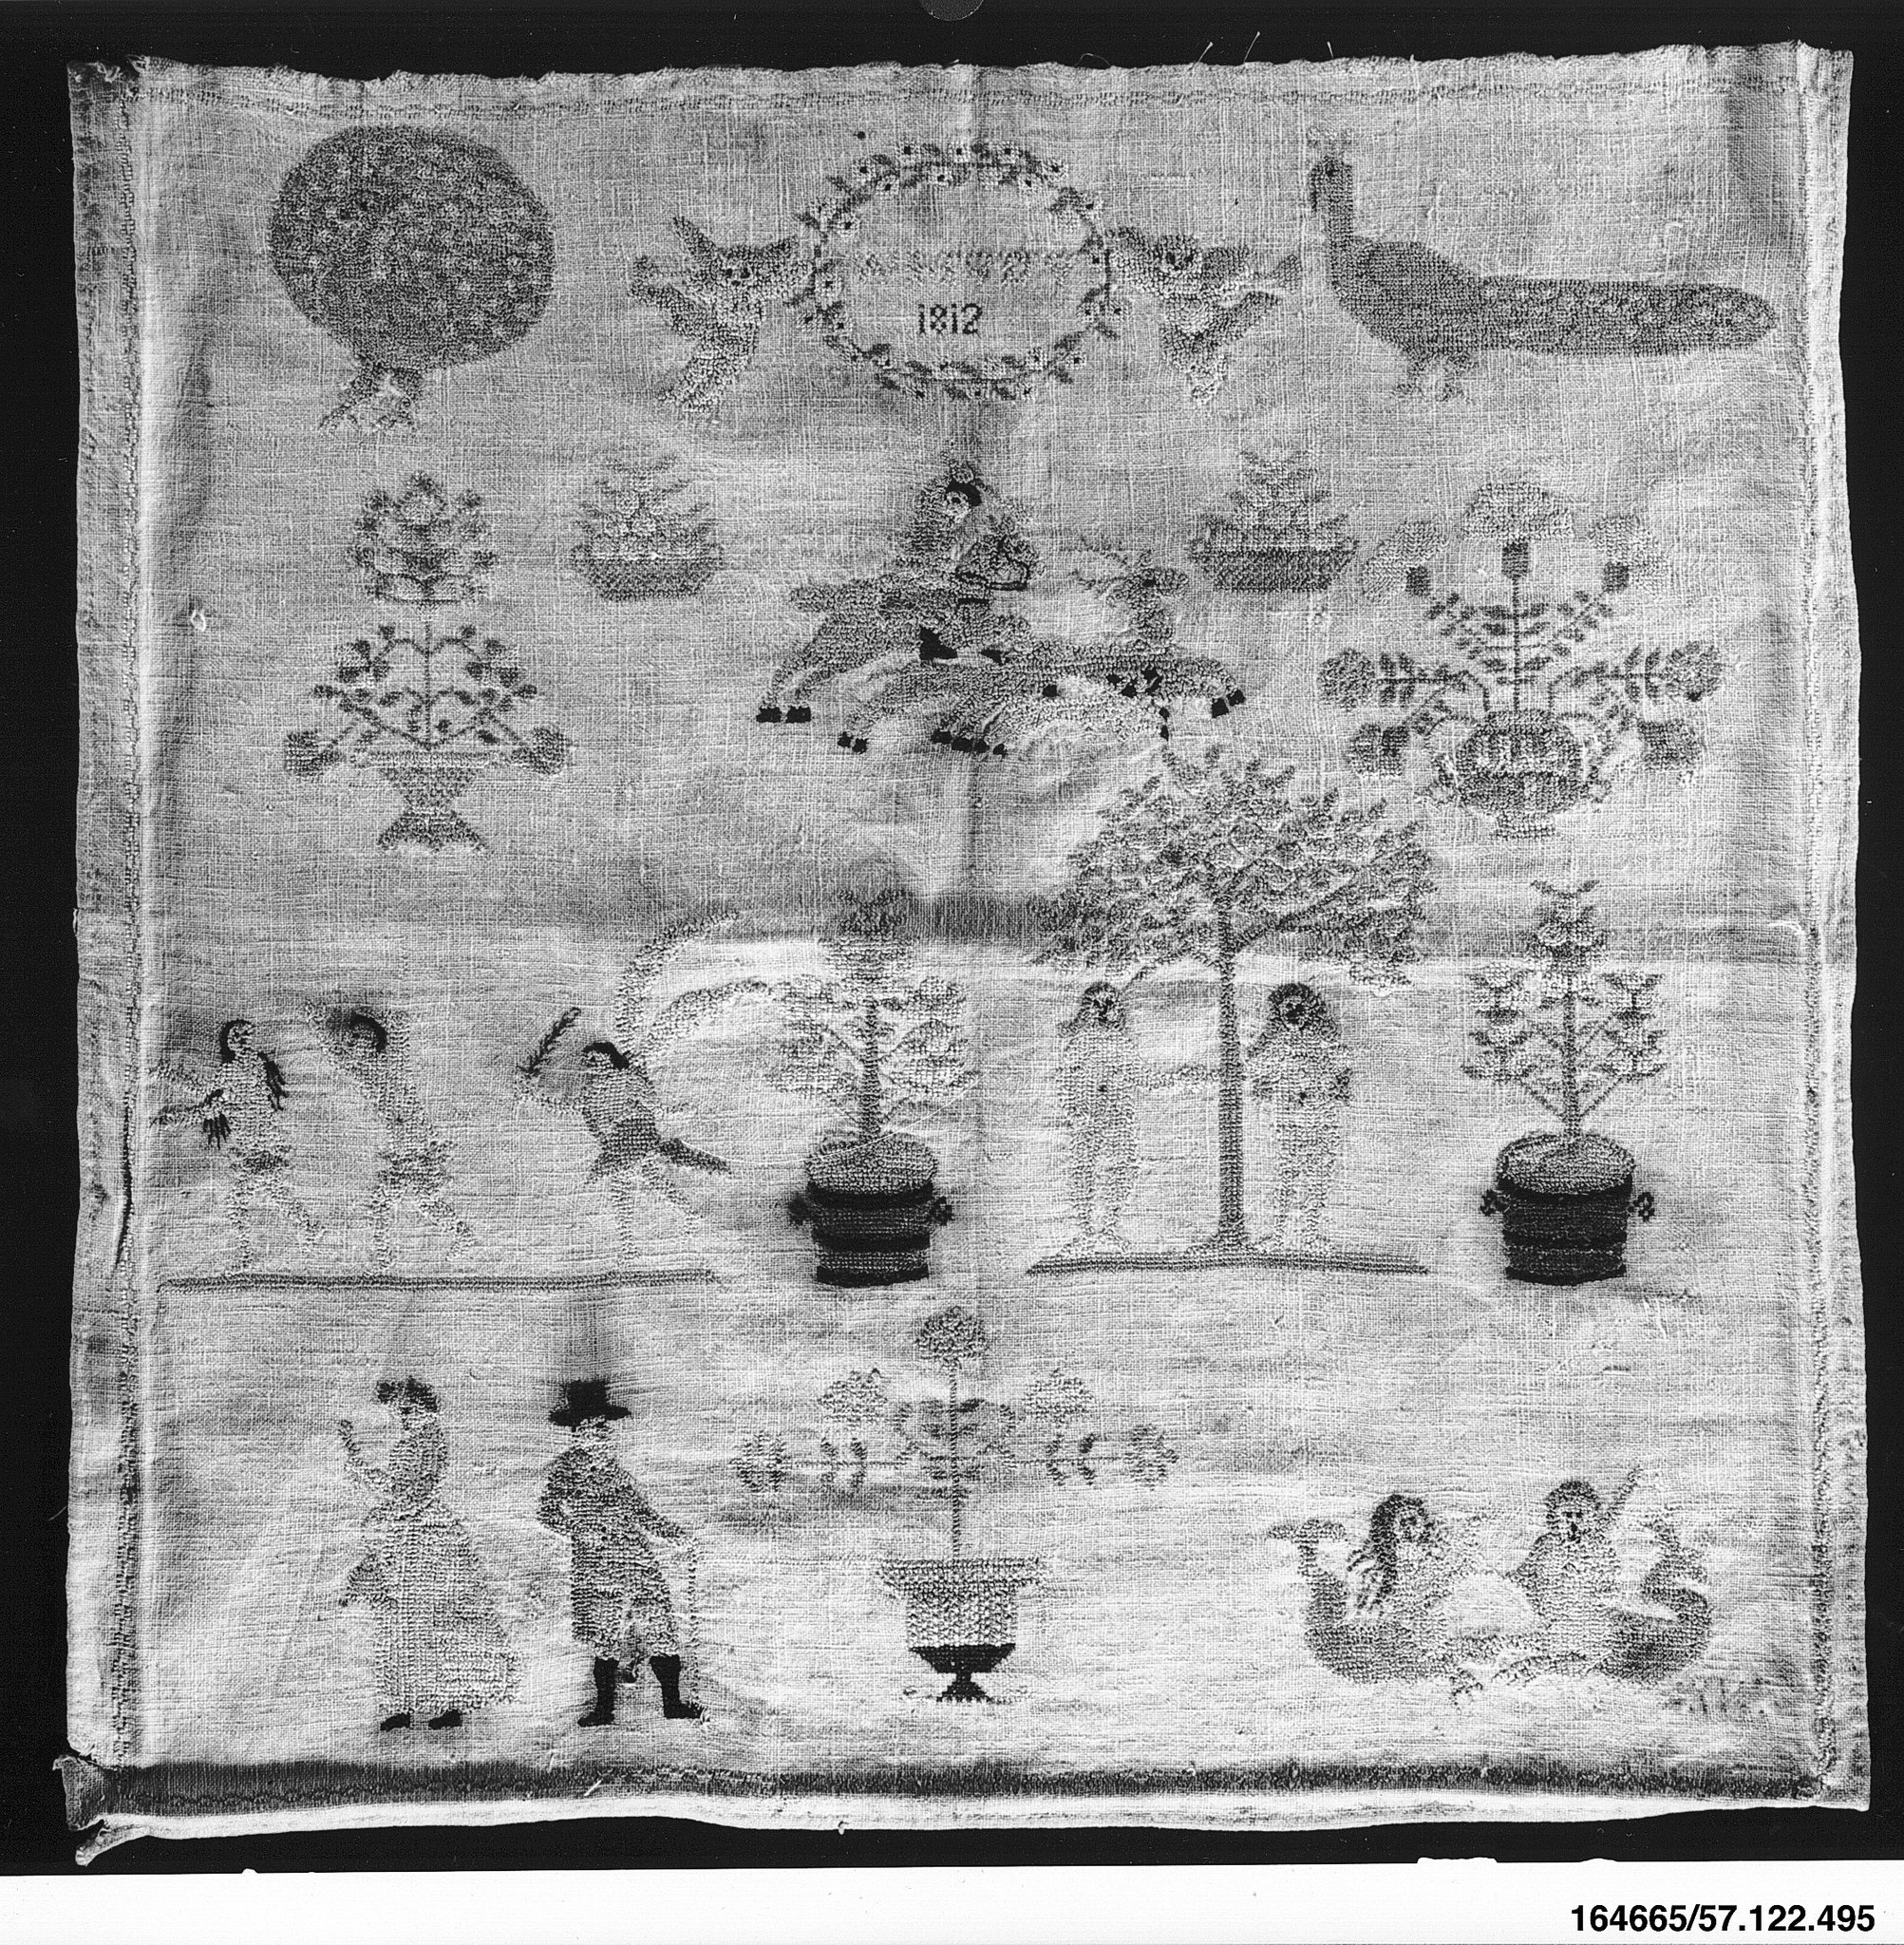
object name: sampler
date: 1812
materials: cotton, silk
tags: human figures,peacocks,plants